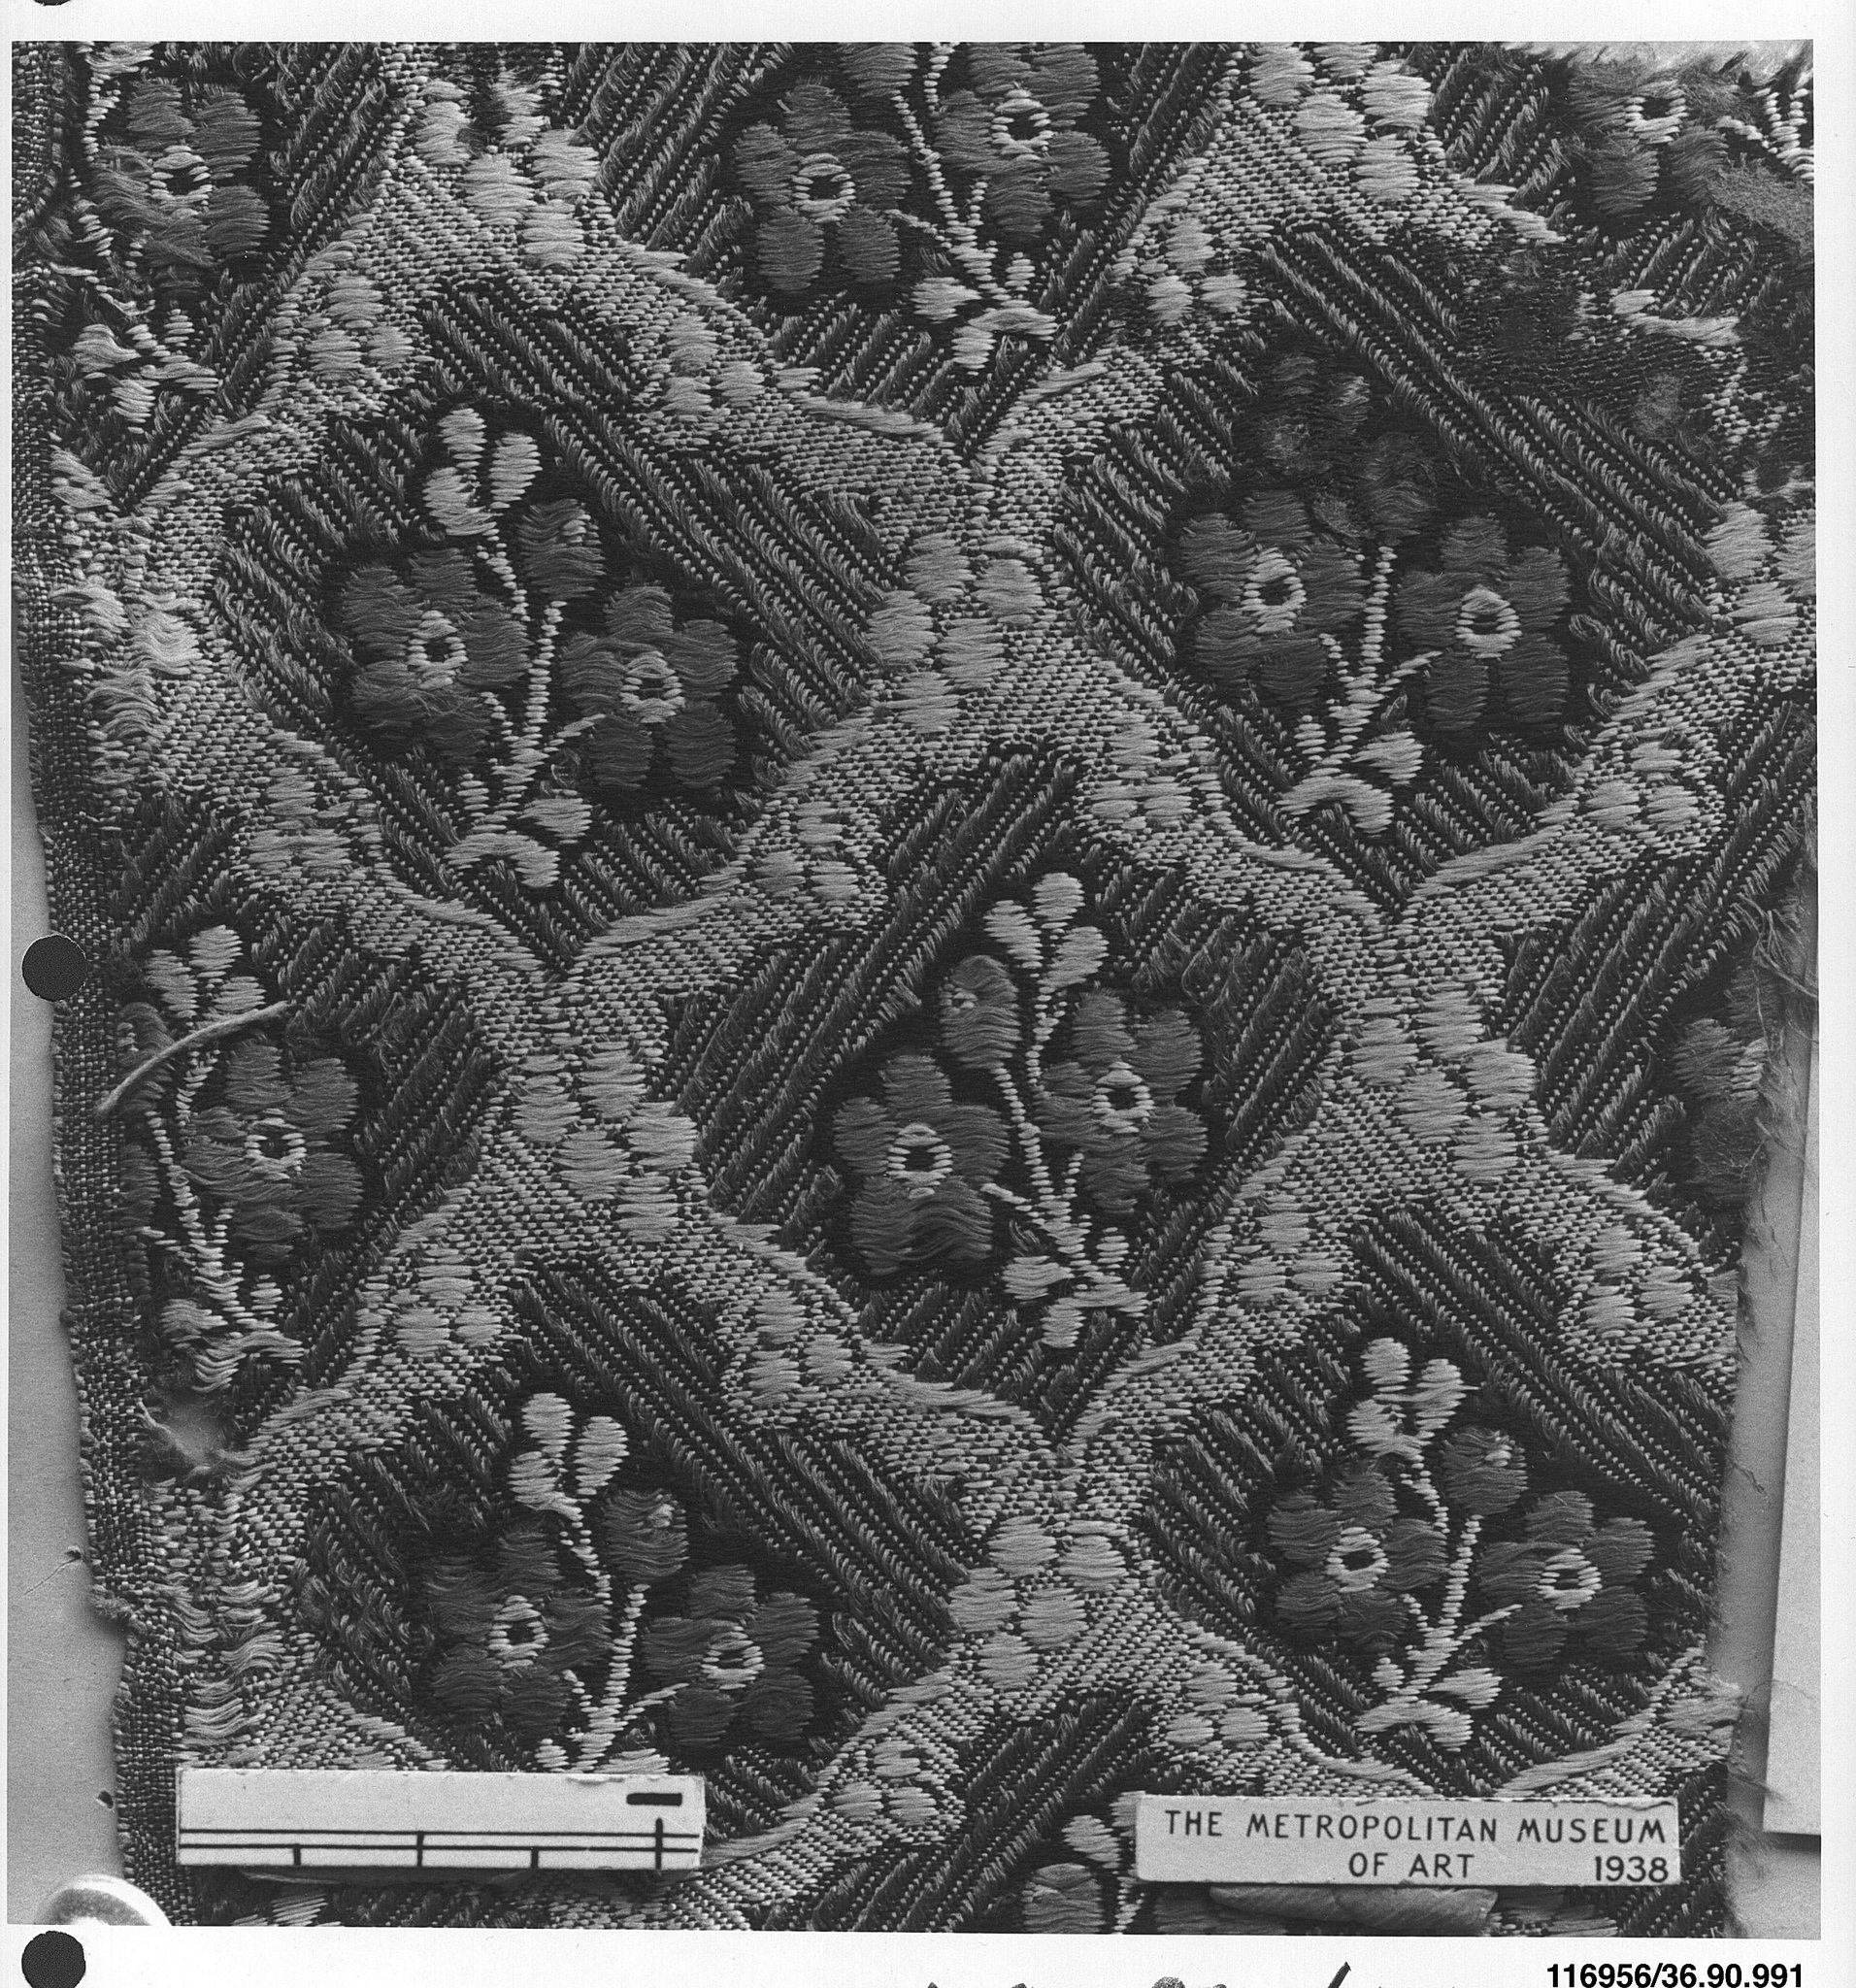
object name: piece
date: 1701-1800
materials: silk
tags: flowers,leaves